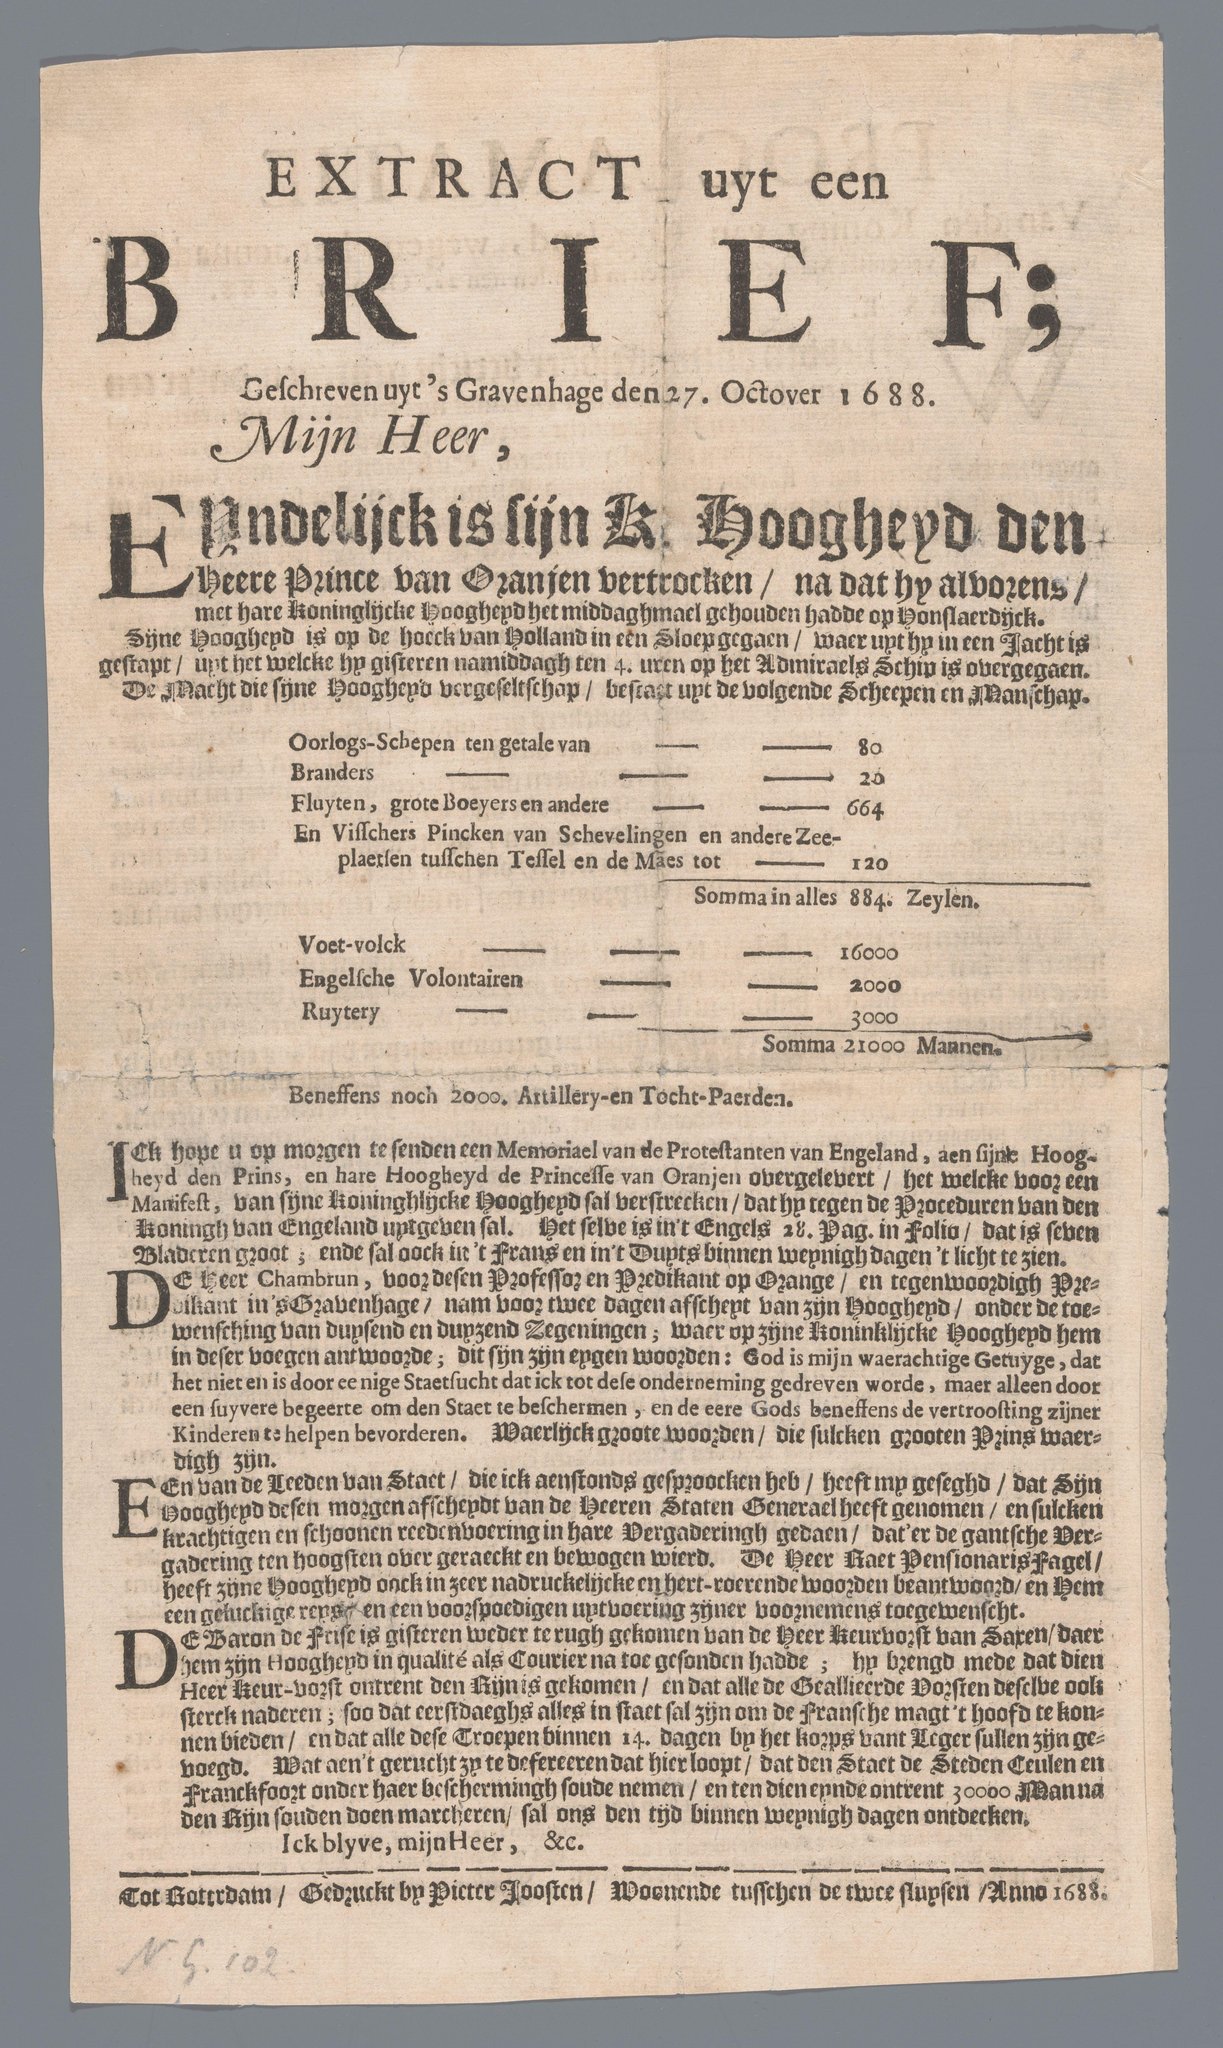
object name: pamphlet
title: Extract uyt een Brief / Proclamatie van den Koning van Engeland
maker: pieter joosten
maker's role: verkoper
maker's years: 1644-1688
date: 1688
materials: paper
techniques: printing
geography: rotterdam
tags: the hague, william iii (prince of orange and king of england, scotland, and ireland)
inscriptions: date